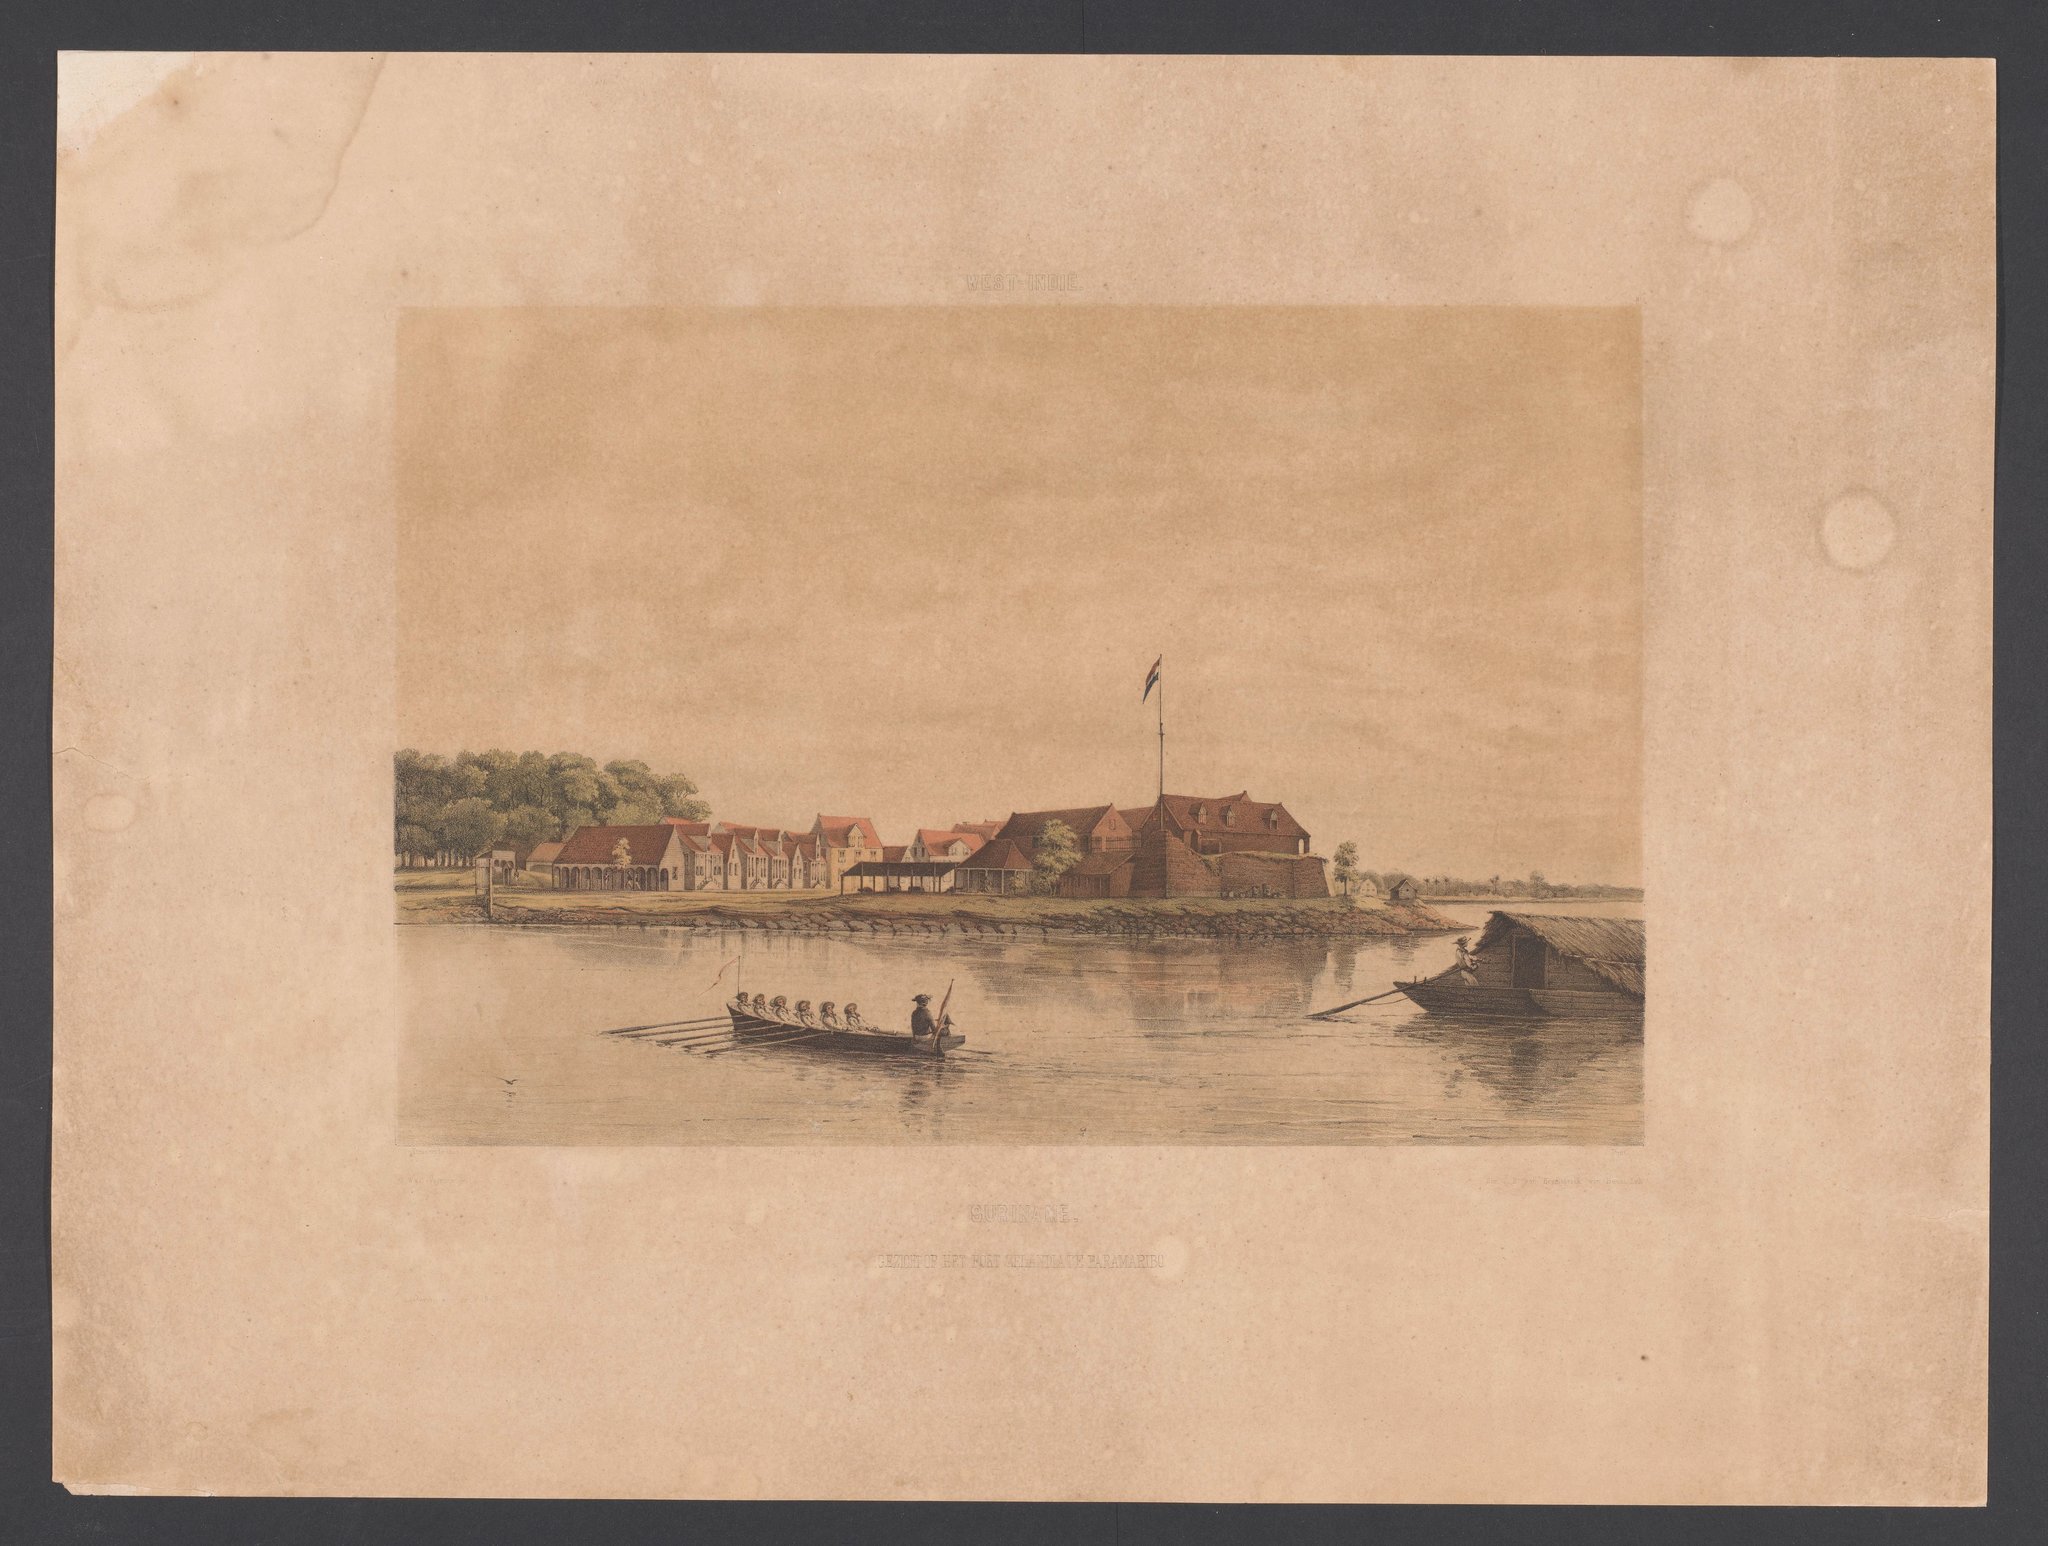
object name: print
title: West-Indië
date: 1860-1862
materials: paper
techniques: lithograph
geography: netherlands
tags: fortress, rowing-boat, canoe, etc., ferry, suriname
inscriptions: collector's mark: Lugt 2228, collector's mark: Lugt 2760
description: Gezicht op Fort Zeelandia te Paramaribo in Suriname. Op de plaat staan aangegeven: Tamarinde-laan, Officierswoningen en Pont. Prent maakt deel uit van een omslag met zeventien bladen.